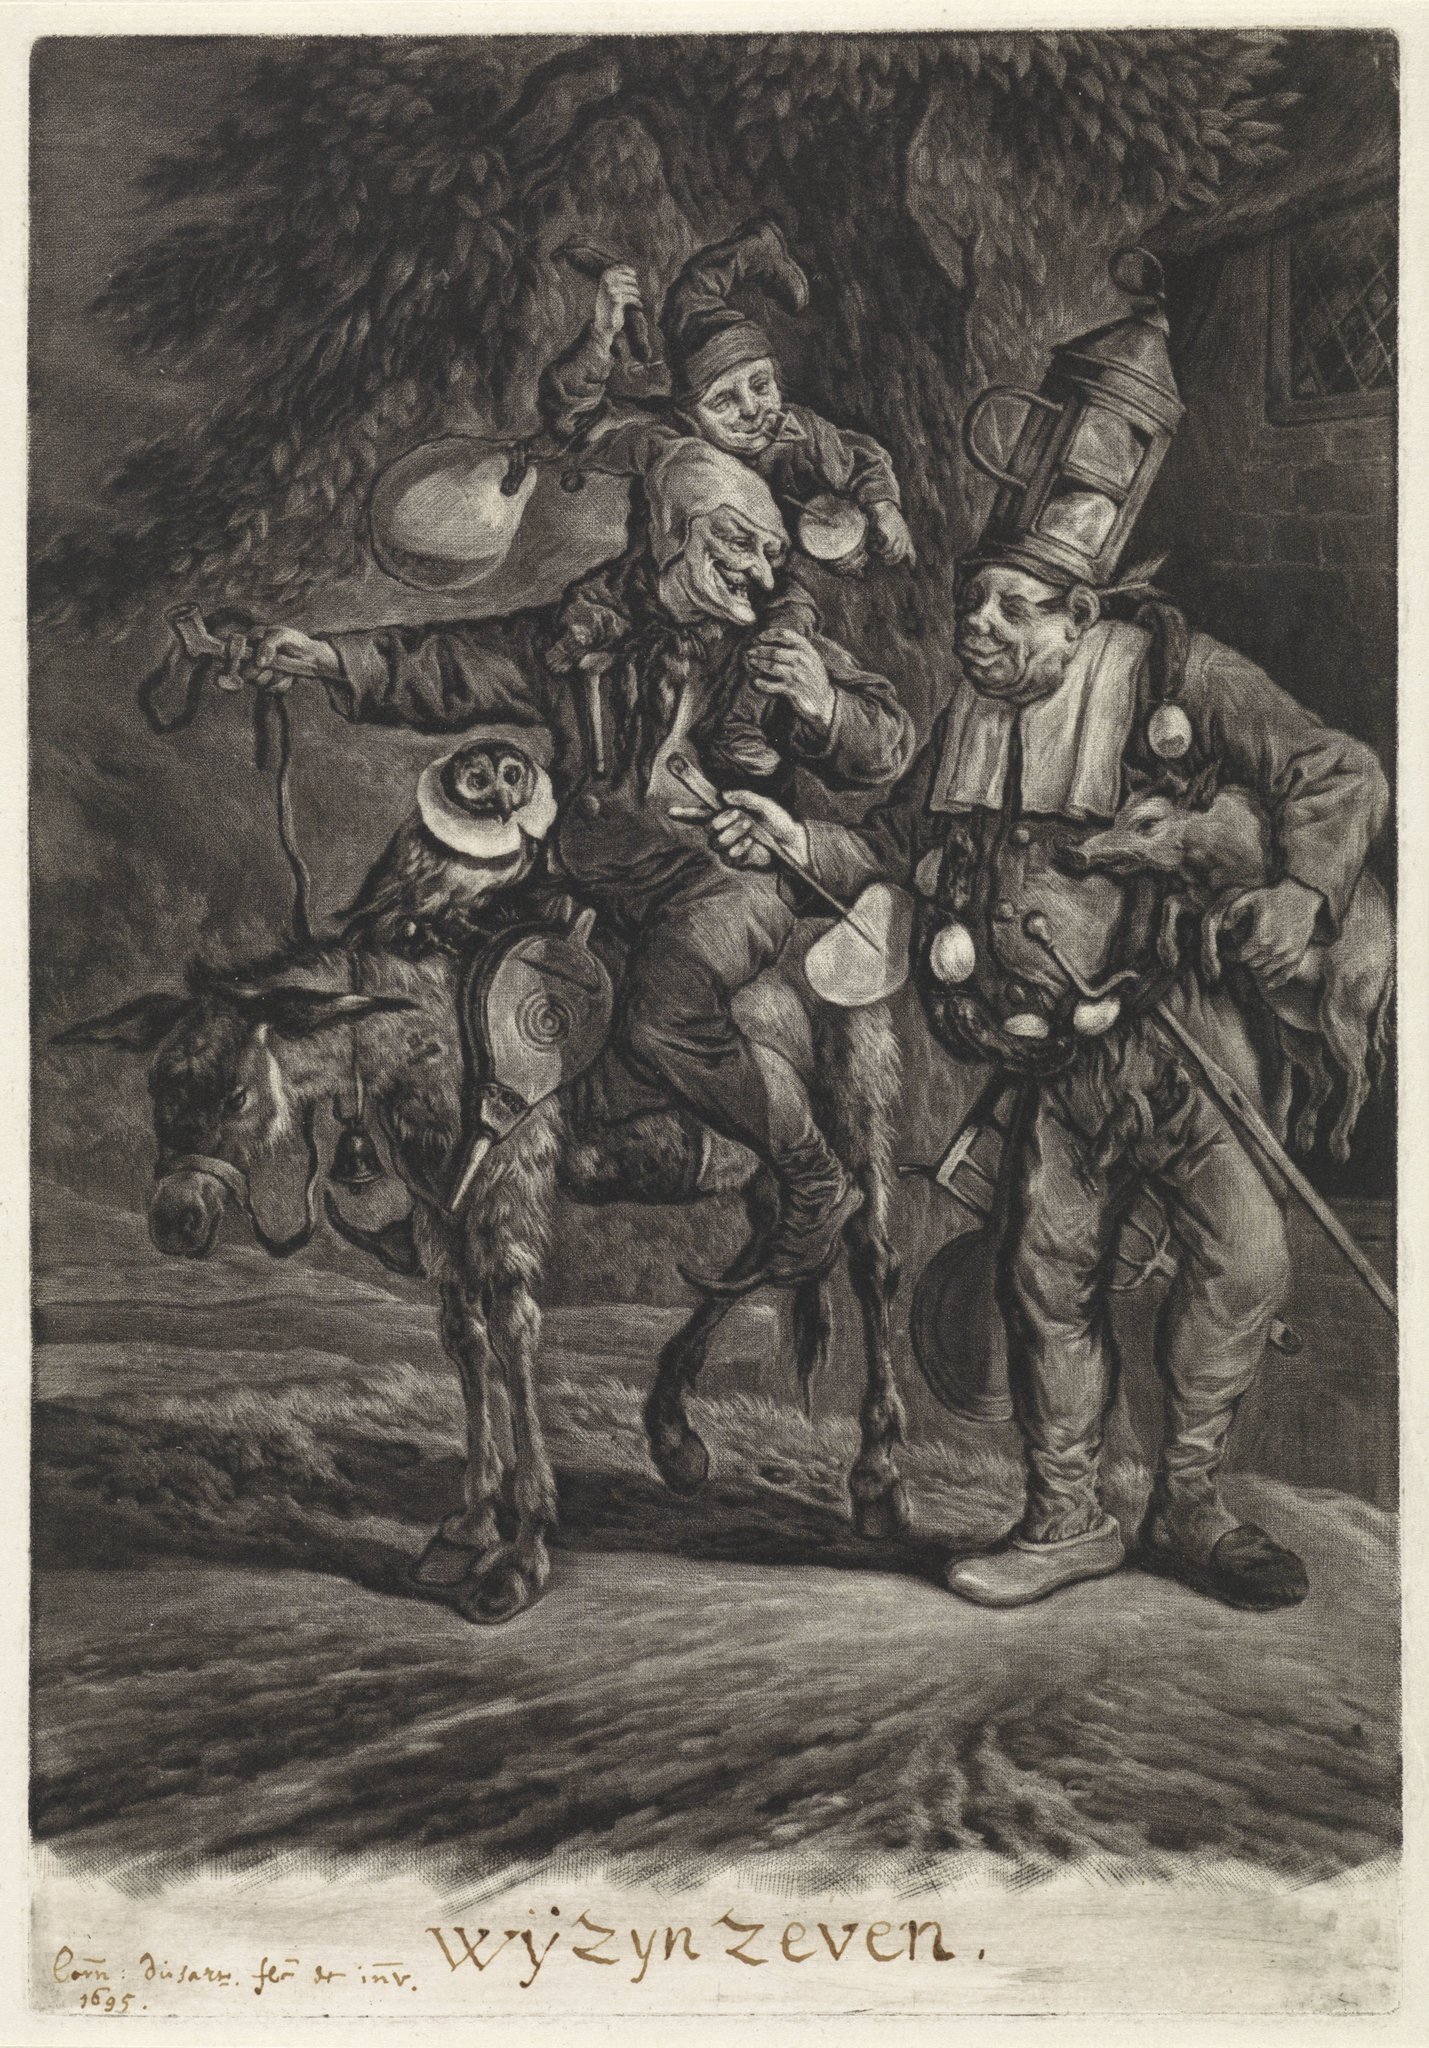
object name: print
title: Wy syn seven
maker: cornelis dusart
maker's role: draughtsman, painter, print maker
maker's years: 1660-1704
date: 1695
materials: paper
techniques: pen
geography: haarlem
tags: pig, ass, donkey, fool, simpleton, numskull, attributes of minerva: owl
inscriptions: inscription: ‘Wy zyn zeven / Corn: dusart fec [...] inv. / 1695’, collector's mark: Lugt 240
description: Drie mensen en drie dieren in een groteske opstelling. Een ezel draagt een uil op zijn nek en twee ruiters op zijn rug. De eerste ruiter is een grijnzende man met een narrekap op het hoofd en ouderwetse puntschoenen aan zijn voeten, een pijp in zijn hand. Op zijn schouders zit een kleine man met een schoen als hoed op zijn hoofd en een rommelpot onder zijn arm. Zijn mond is met een slot verzegeld. Naast de ezel staat een dikke dom-lachende man met een lantaarn op zijn hoofd. Om zijn buik hangen worsten en eieren en onder zijn arm draagt hij een varkentje.